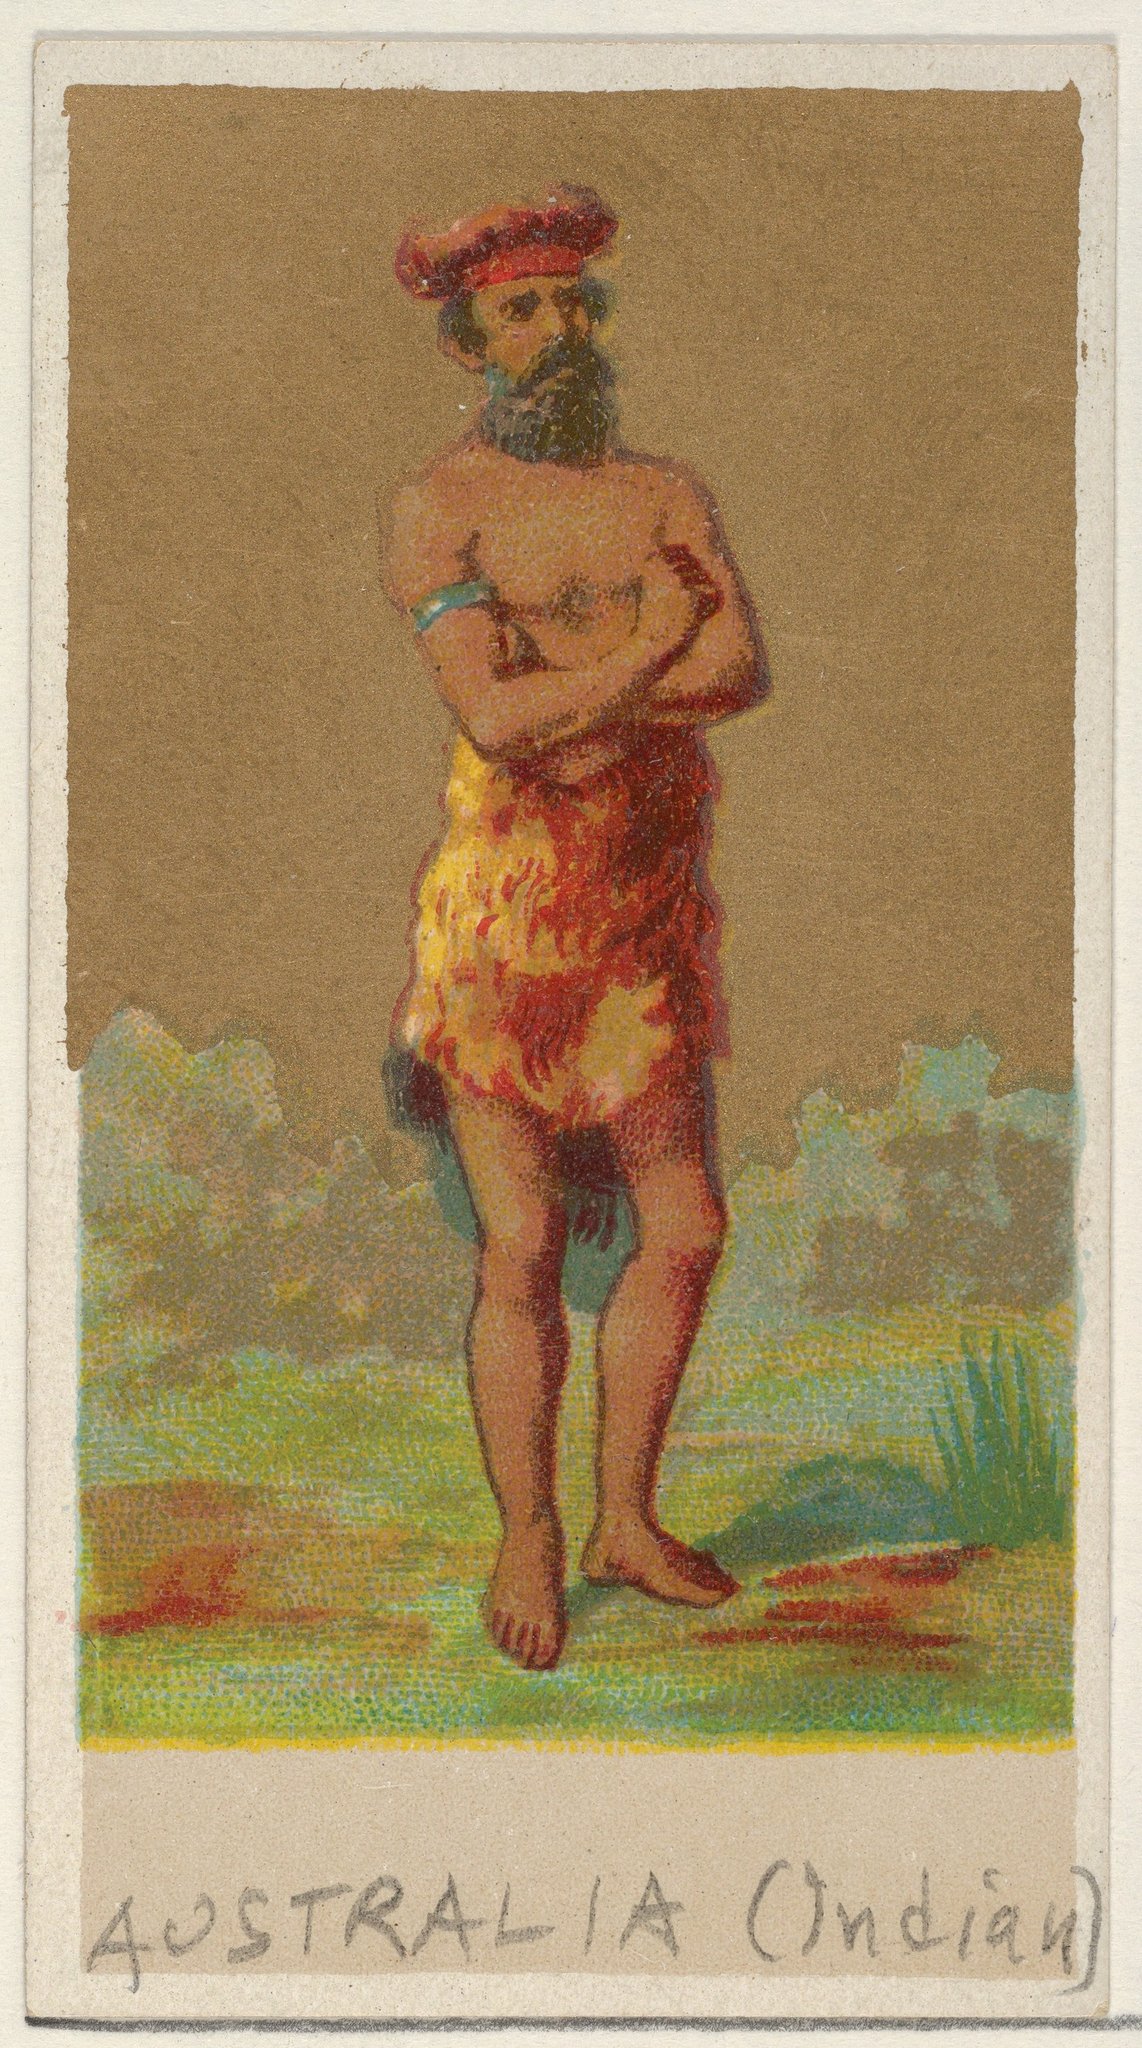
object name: print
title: Australia (Indian), from the Natives in Costume series (N16), Teofani Issue, for Allen & Ginter Cigarettes Brands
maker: allen & ginter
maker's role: publisher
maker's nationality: american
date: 1886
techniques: color lithograph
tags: men